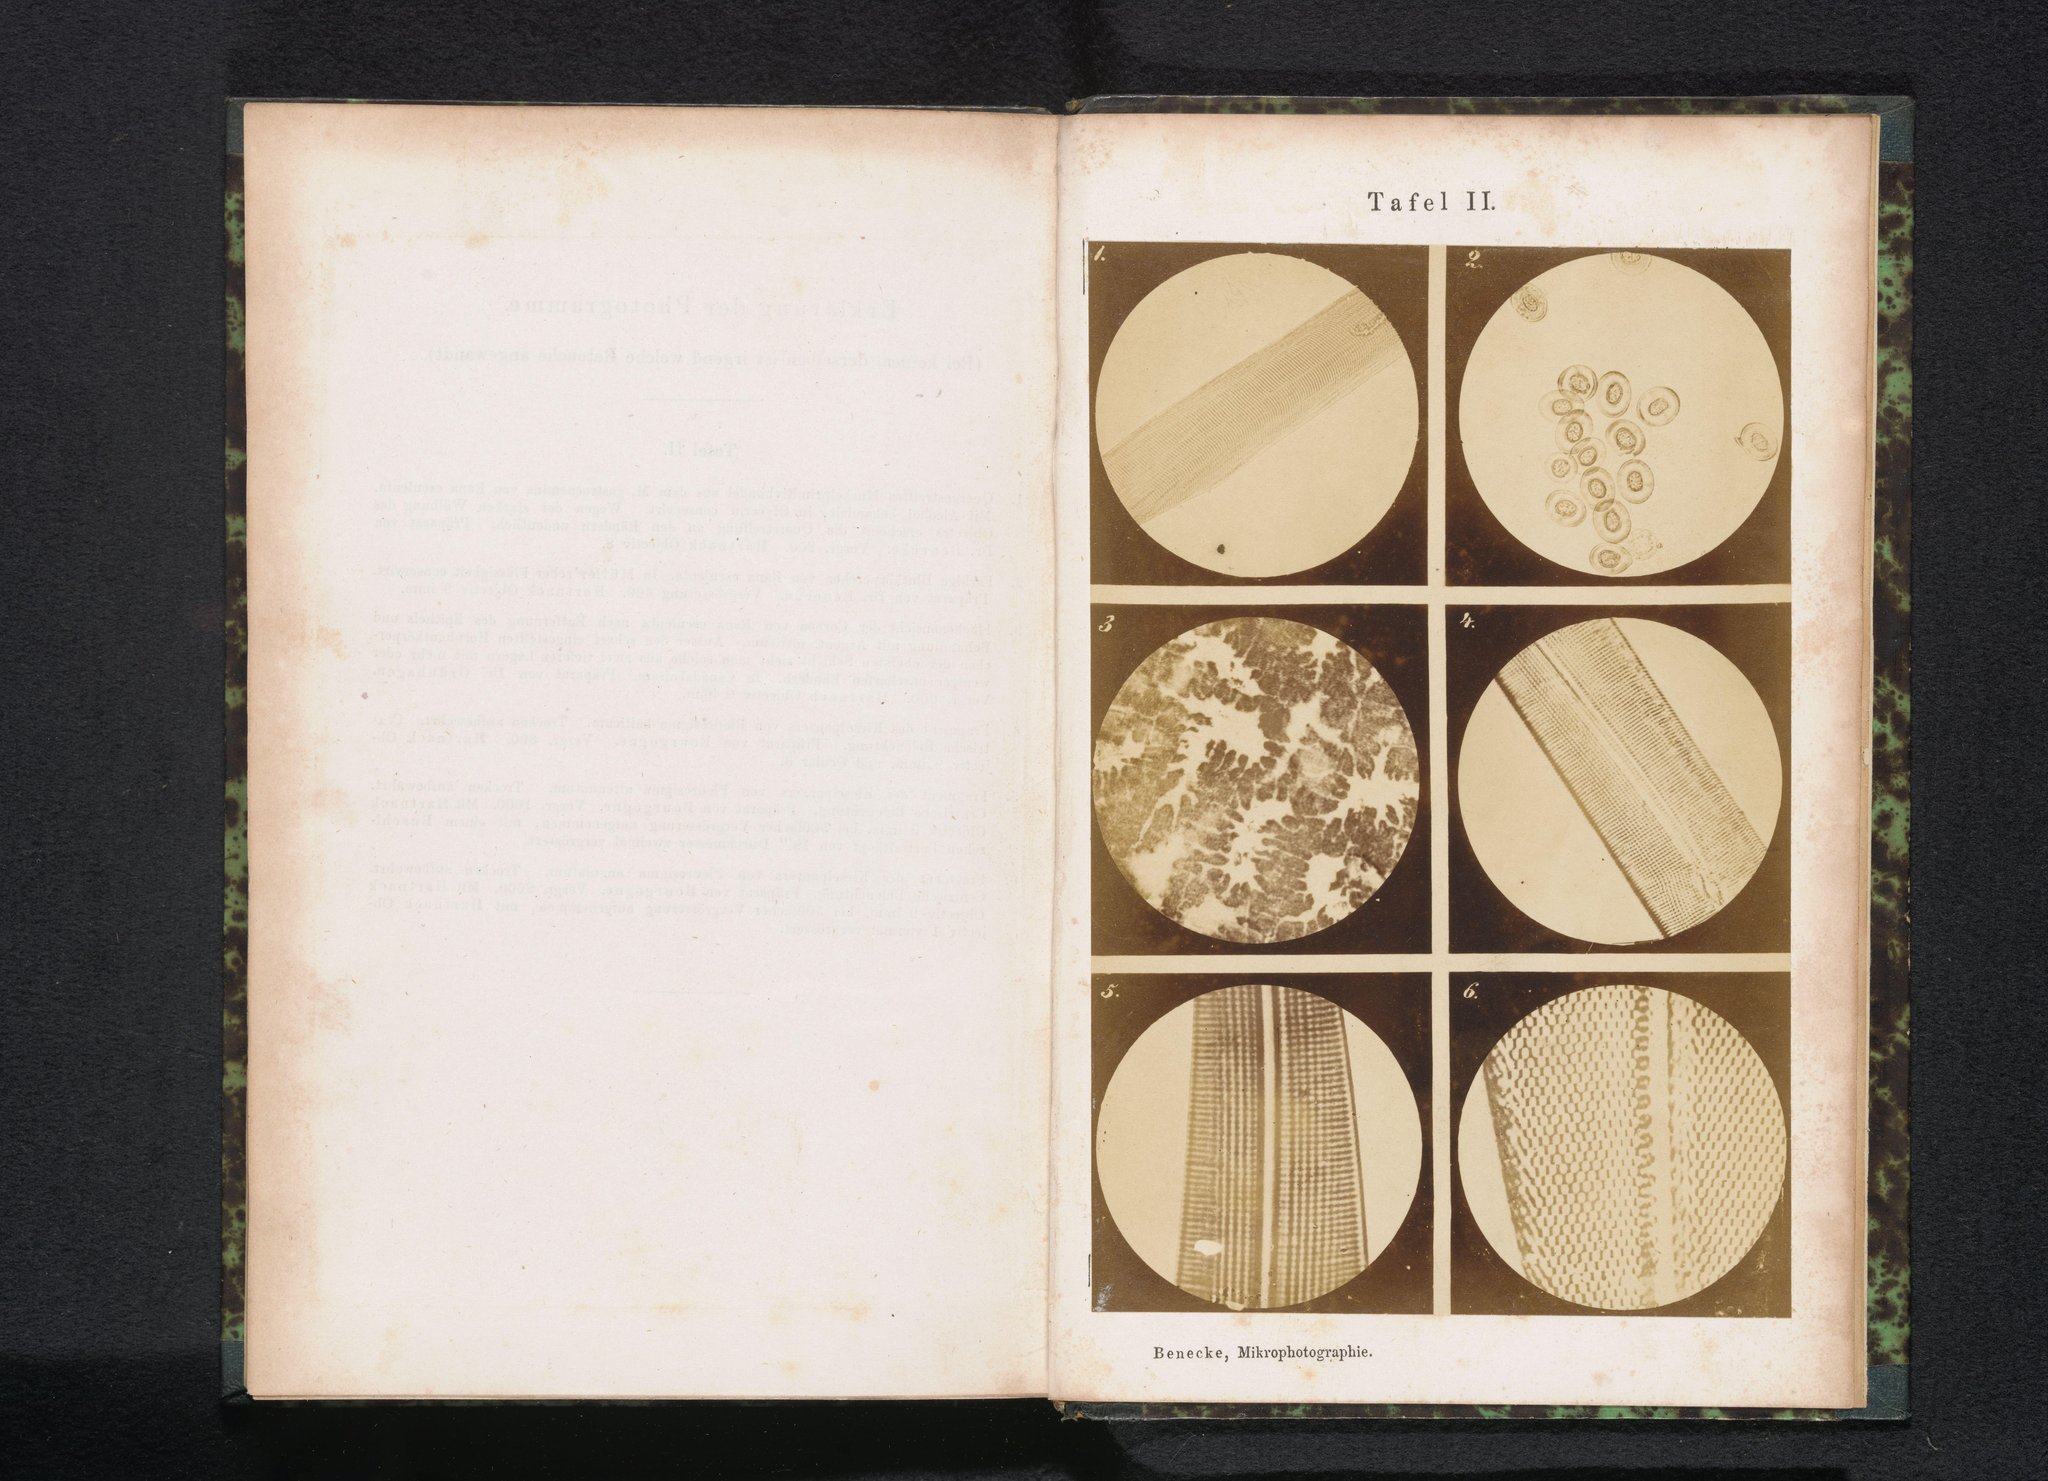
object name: page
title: Zes microscopische vergrotingen van onderdelen van het menselijk lichaam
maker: berthold benecke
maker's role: anatoom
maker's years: 1843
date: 1858-1868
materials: photographic support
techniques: albumen print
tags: blood circulation, muscles, other anatomical details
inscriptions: number: ‘1. (...) 6.’, number: ‘Tafel II.’